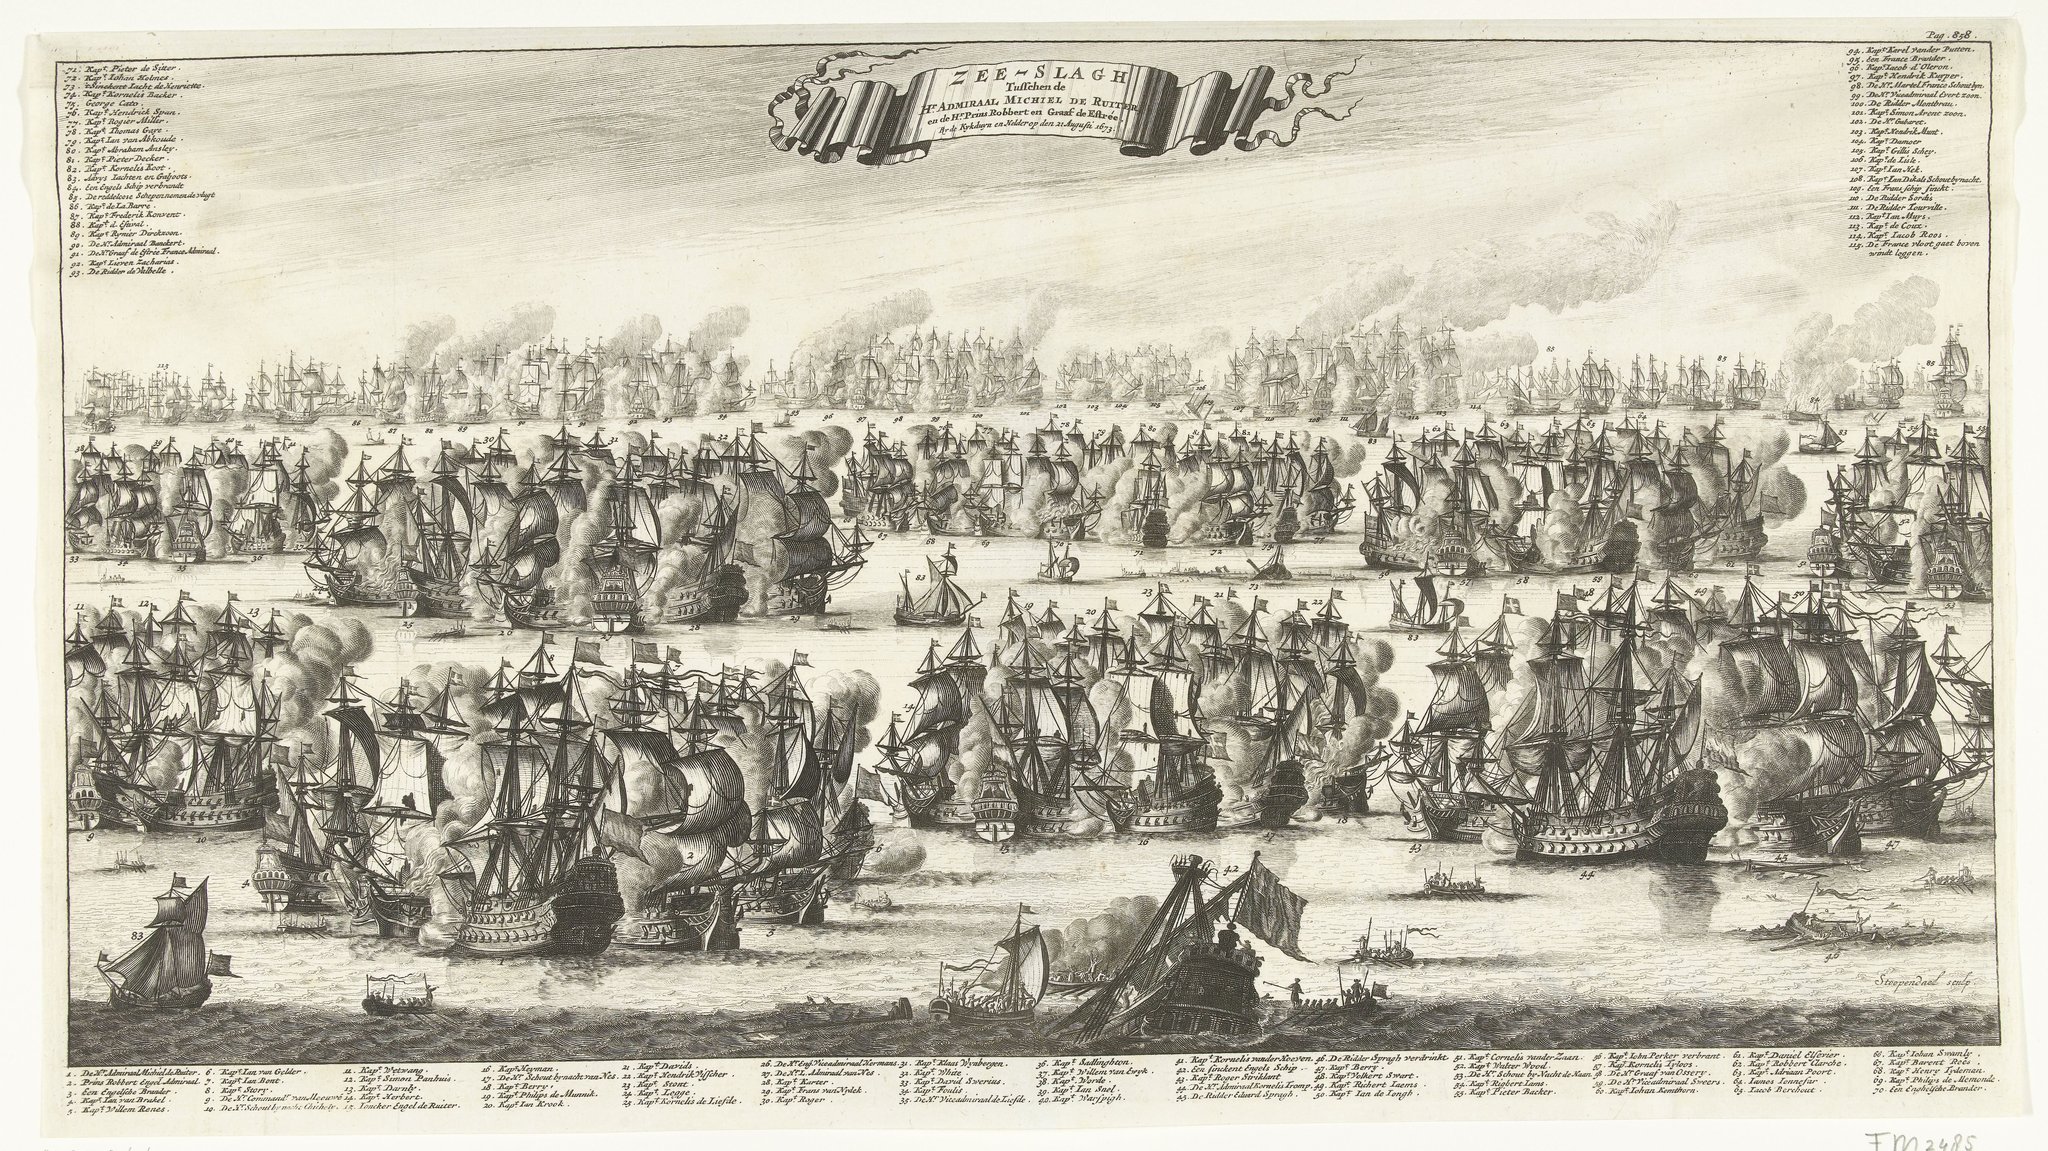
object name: print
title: Zee-Slagh Tusschen de Hr. Admiraal Michiel de Ruiter, en de Hr. Prins Robbert en Graaf de Estrée. By Kykduyn en Helder op den 21. Augusti 1673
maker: bastiaen stopendael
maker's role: print maker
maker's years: 1636-1693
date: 1685-1687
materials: paper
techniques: engraving, etching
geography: northern netherlands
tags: prague, london, painter, print maker, draughtsman, prinz ruprecht, flushing, michiel adriaenszoon de ruyter, rotterdam, amsterdam, cornelis tromp, battle (+ naval force), battle of the texel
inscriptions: signature and date: ‘r.o. in de voorstelling: Stoopendael sculp.’, inscription: ‘M.b. in wimpel de titel: Zee-Slagh....l.b. en r.b. en in de ondermarge de namen van de betreffende kapiteins e.a.’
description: Zeeslag bij Kijkduin, 21 augustus 1673. Zeeslag voor Kijkduin bij Den Helder en Texel tussen de Staatse vloot onder Michiel Adriaenszoon de Ruyter en Cornelis Tromp en de gecombineerde Engels-Franse vloot onder prins Rupert en de graaf Jean d'Estrées (II). Onderaan en bovenaan de legenda 1-115 in 3 delen.